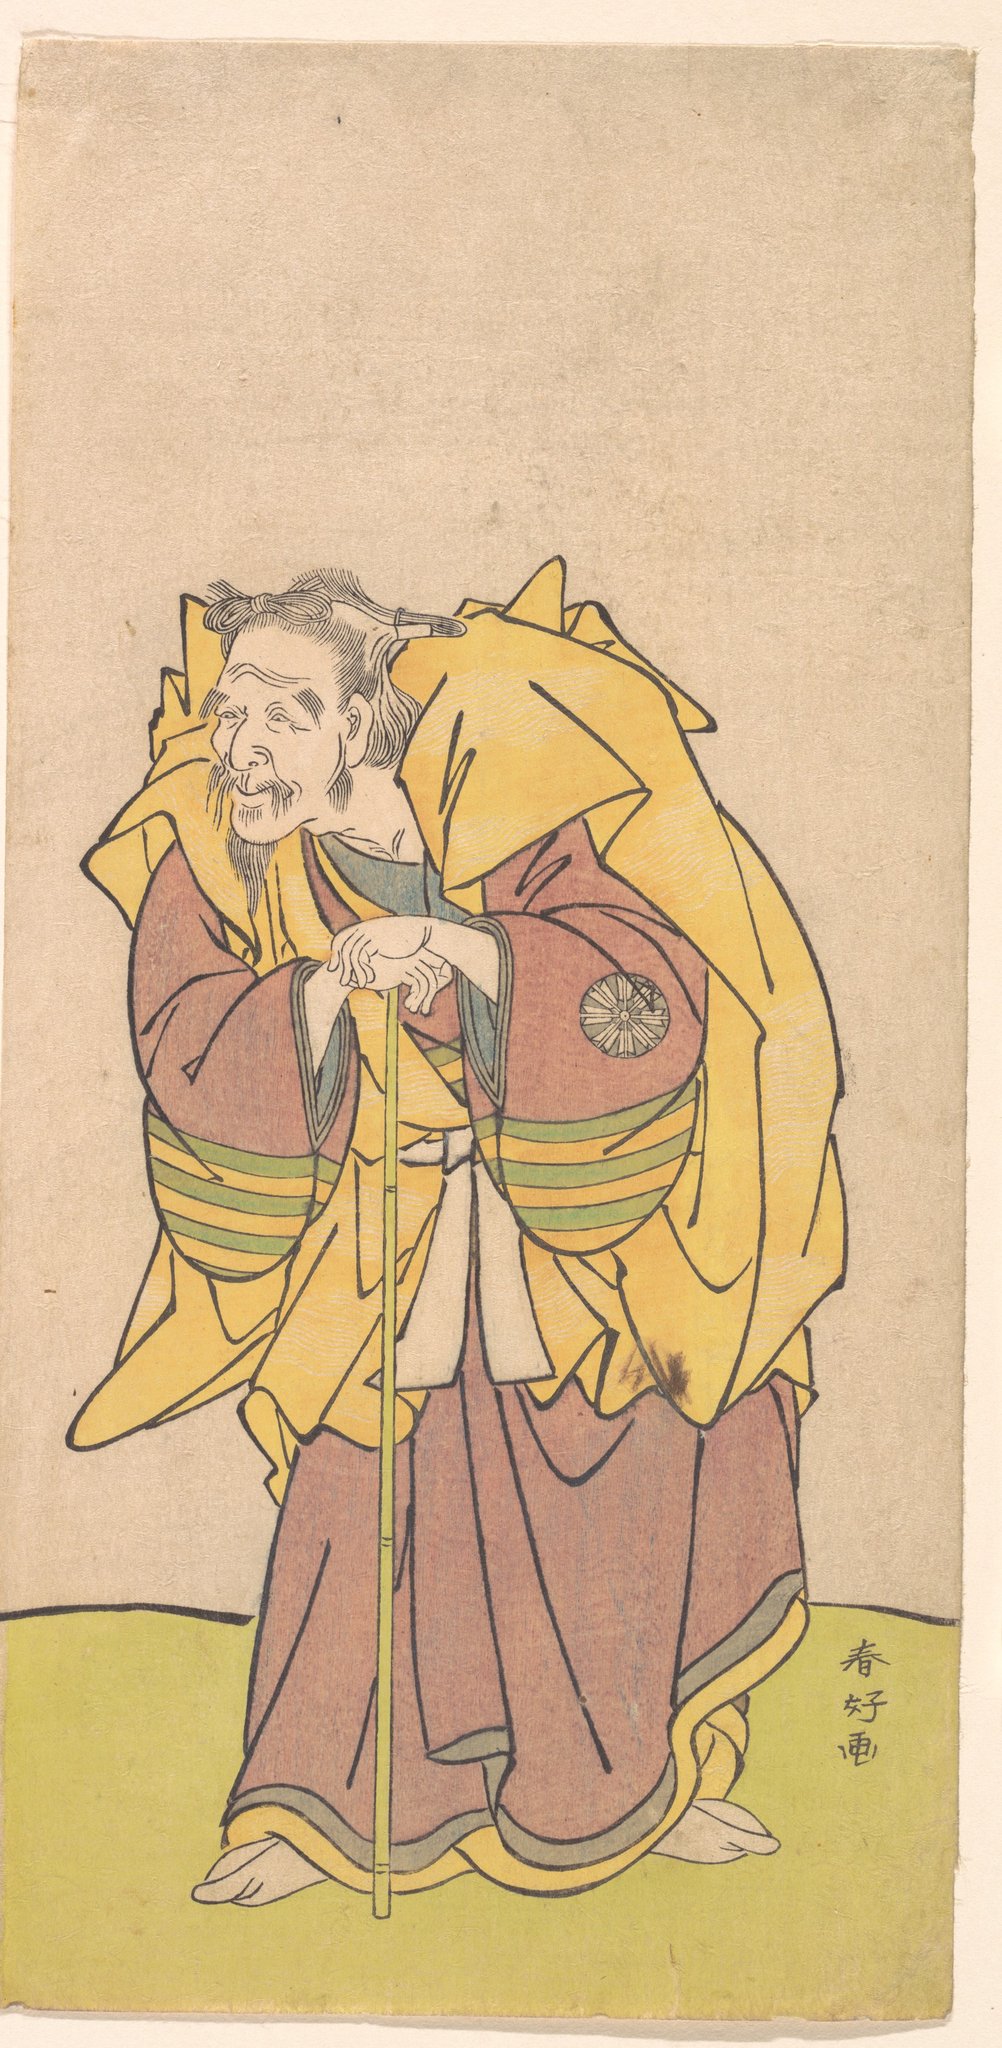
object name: print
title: Nakamura Tomijuro as an Old Man with a Scanty Beard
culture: japanese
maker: katsukawa shunkō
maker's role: artist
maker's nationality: japanese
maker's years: 1743-1812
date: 1780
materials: ink, paper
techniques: woodblock print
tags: men,actors